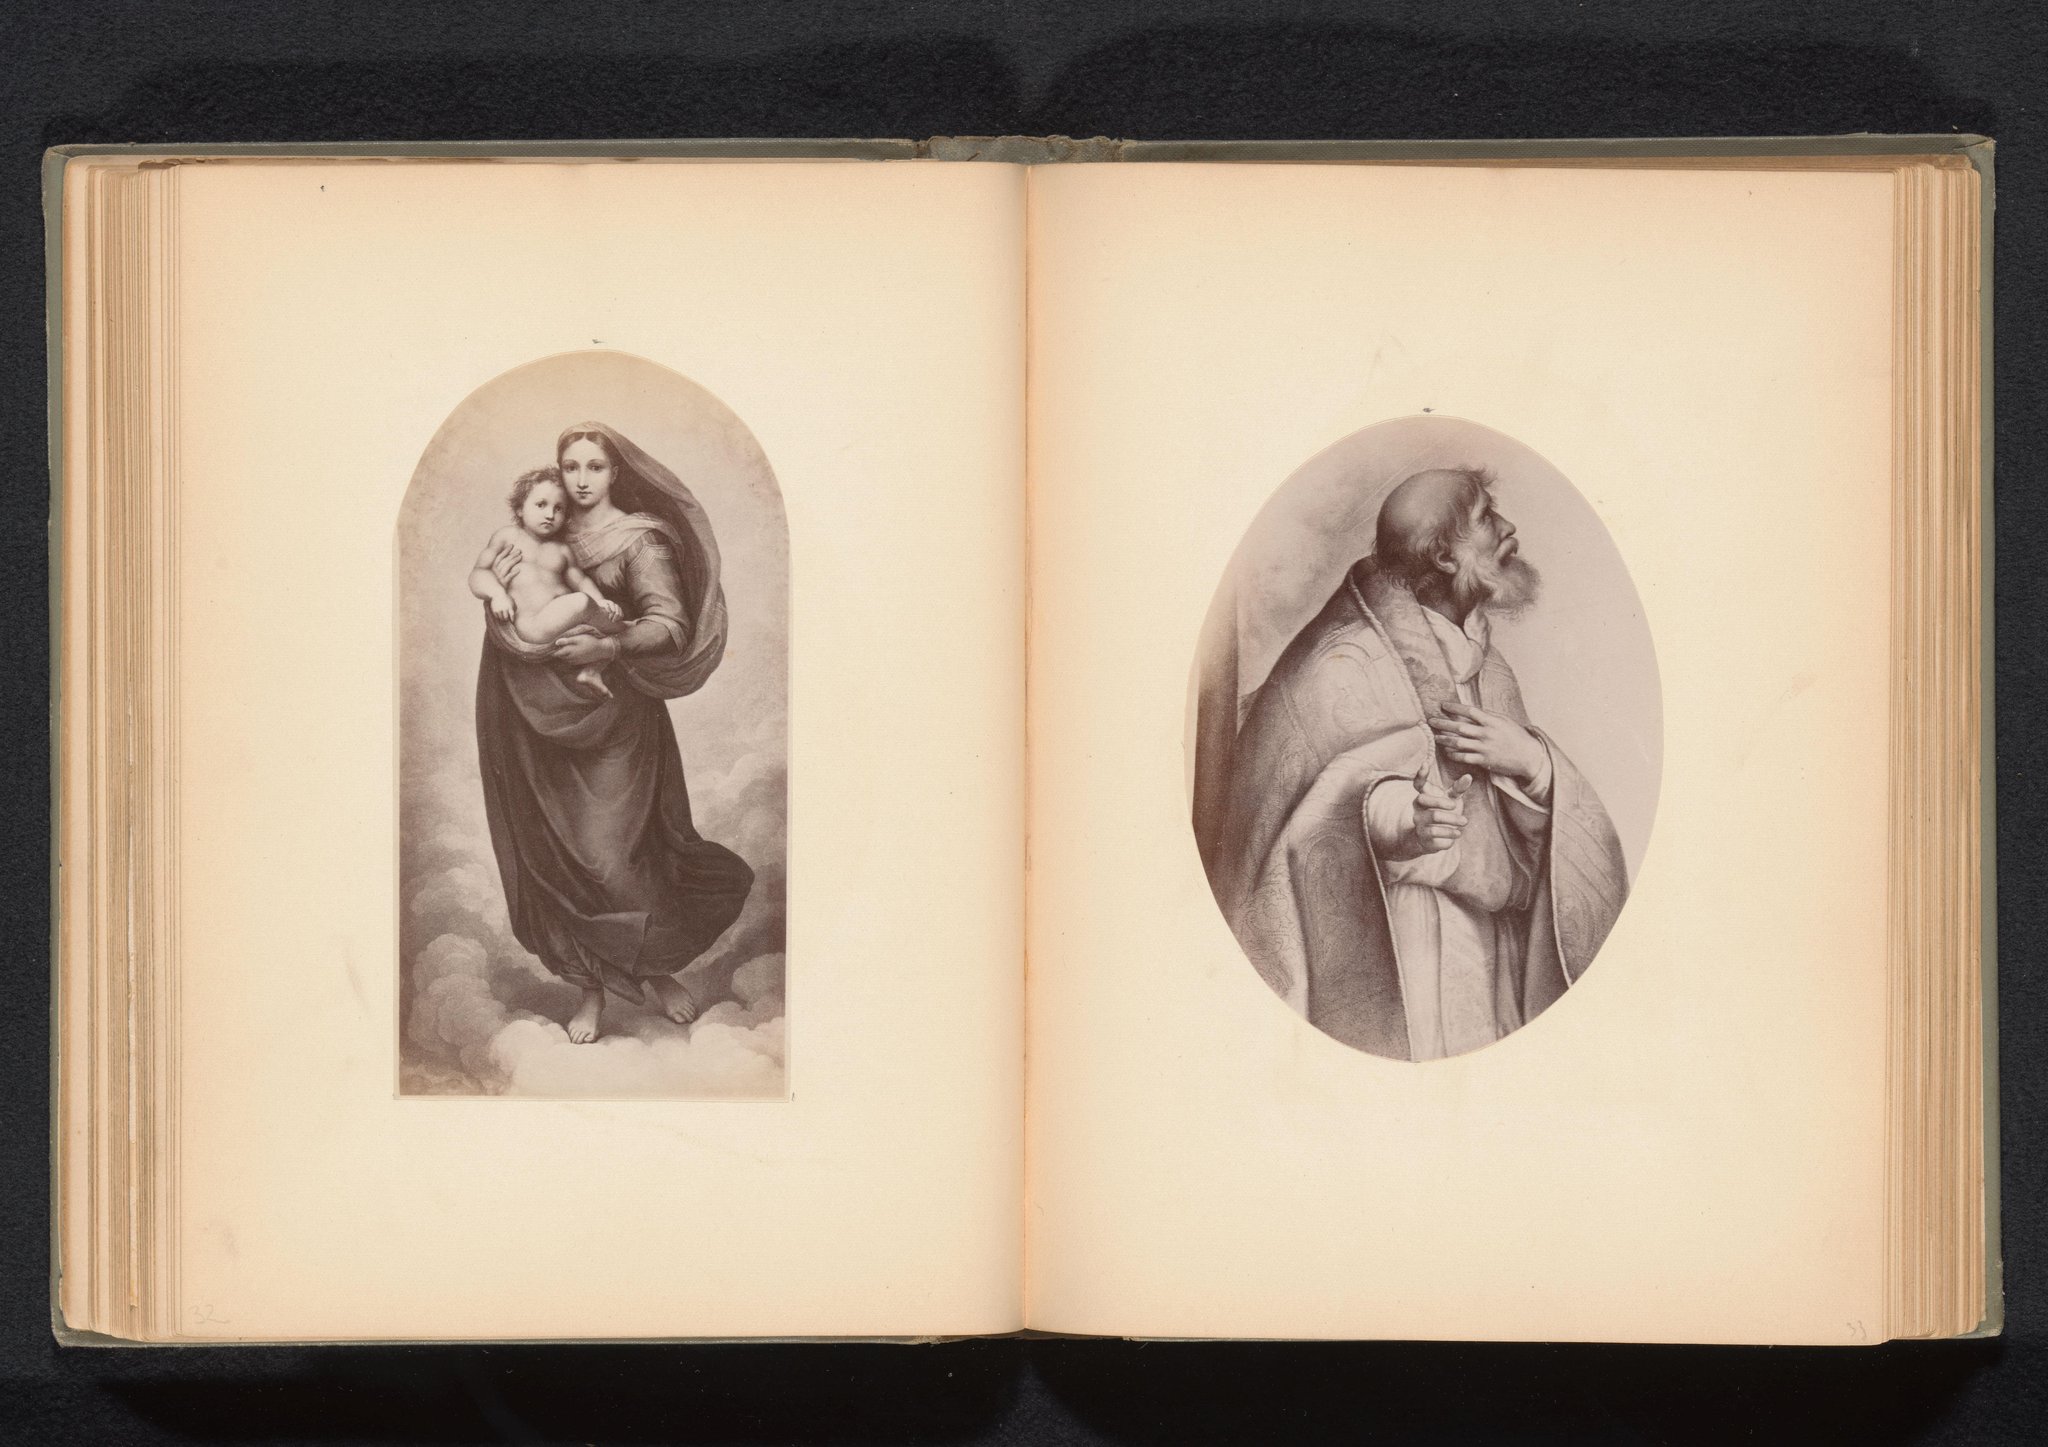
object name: reproduction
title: Fotoreproductie van een prent naar een schilderij, voorstellende de Sixtijnse Madonna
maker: Anonymous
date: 1882-1887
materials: photographic support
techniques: albumen print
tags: madonna: i.e. mary with the christ-child